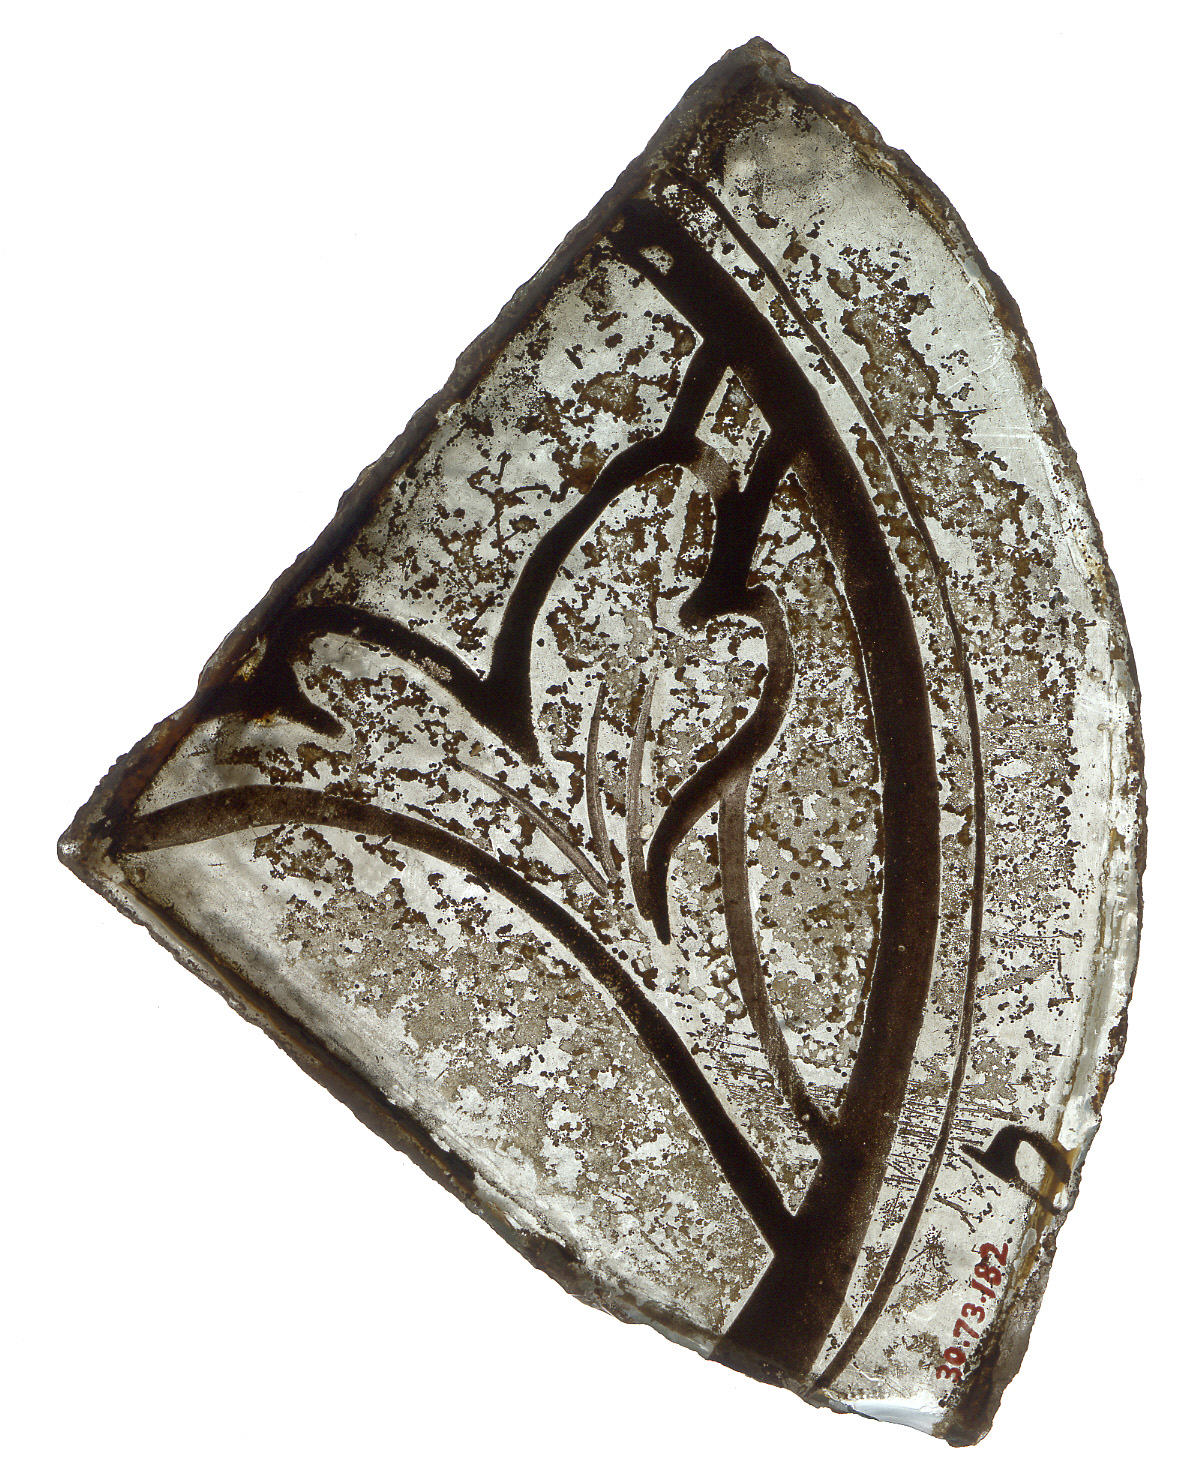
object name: fragment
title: Glass Fragment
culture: french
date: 1101-1200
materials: glass, paint